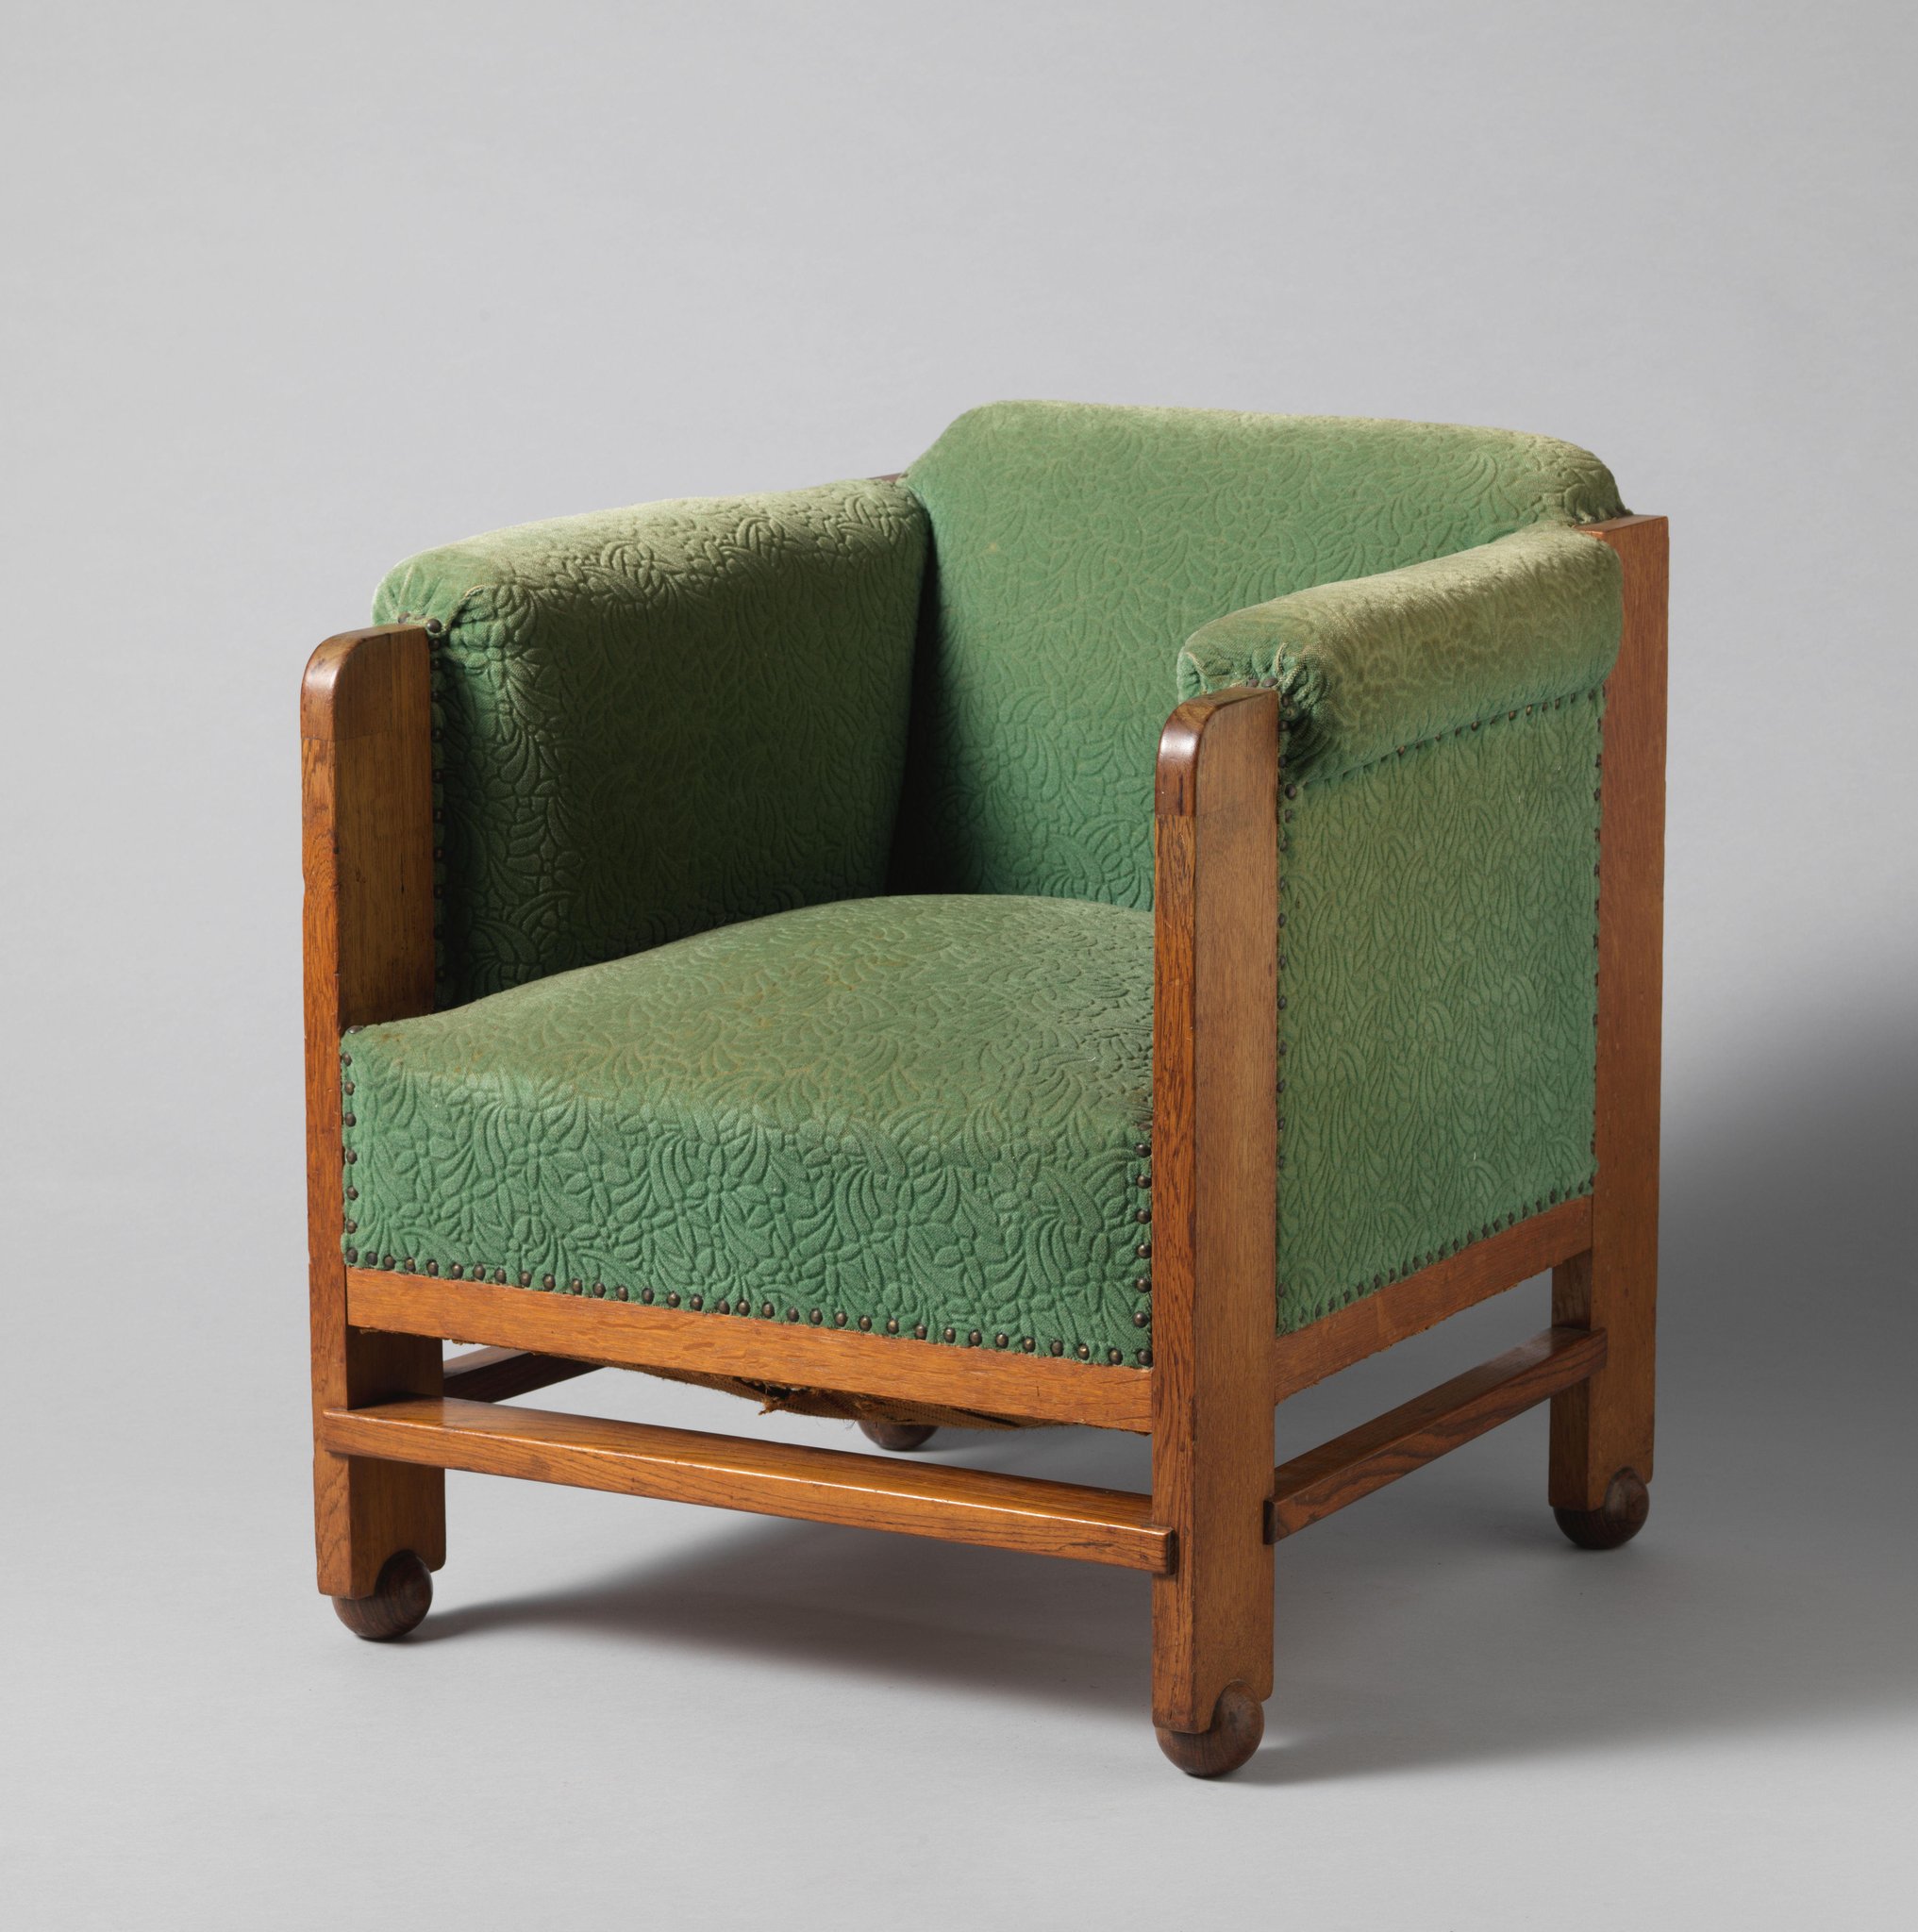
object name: seating furniture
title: Fauteuil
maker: ernst schubad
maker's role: interieurontwerper, meubelontwerper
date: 1910-1927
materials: wood, wool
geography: netherlands